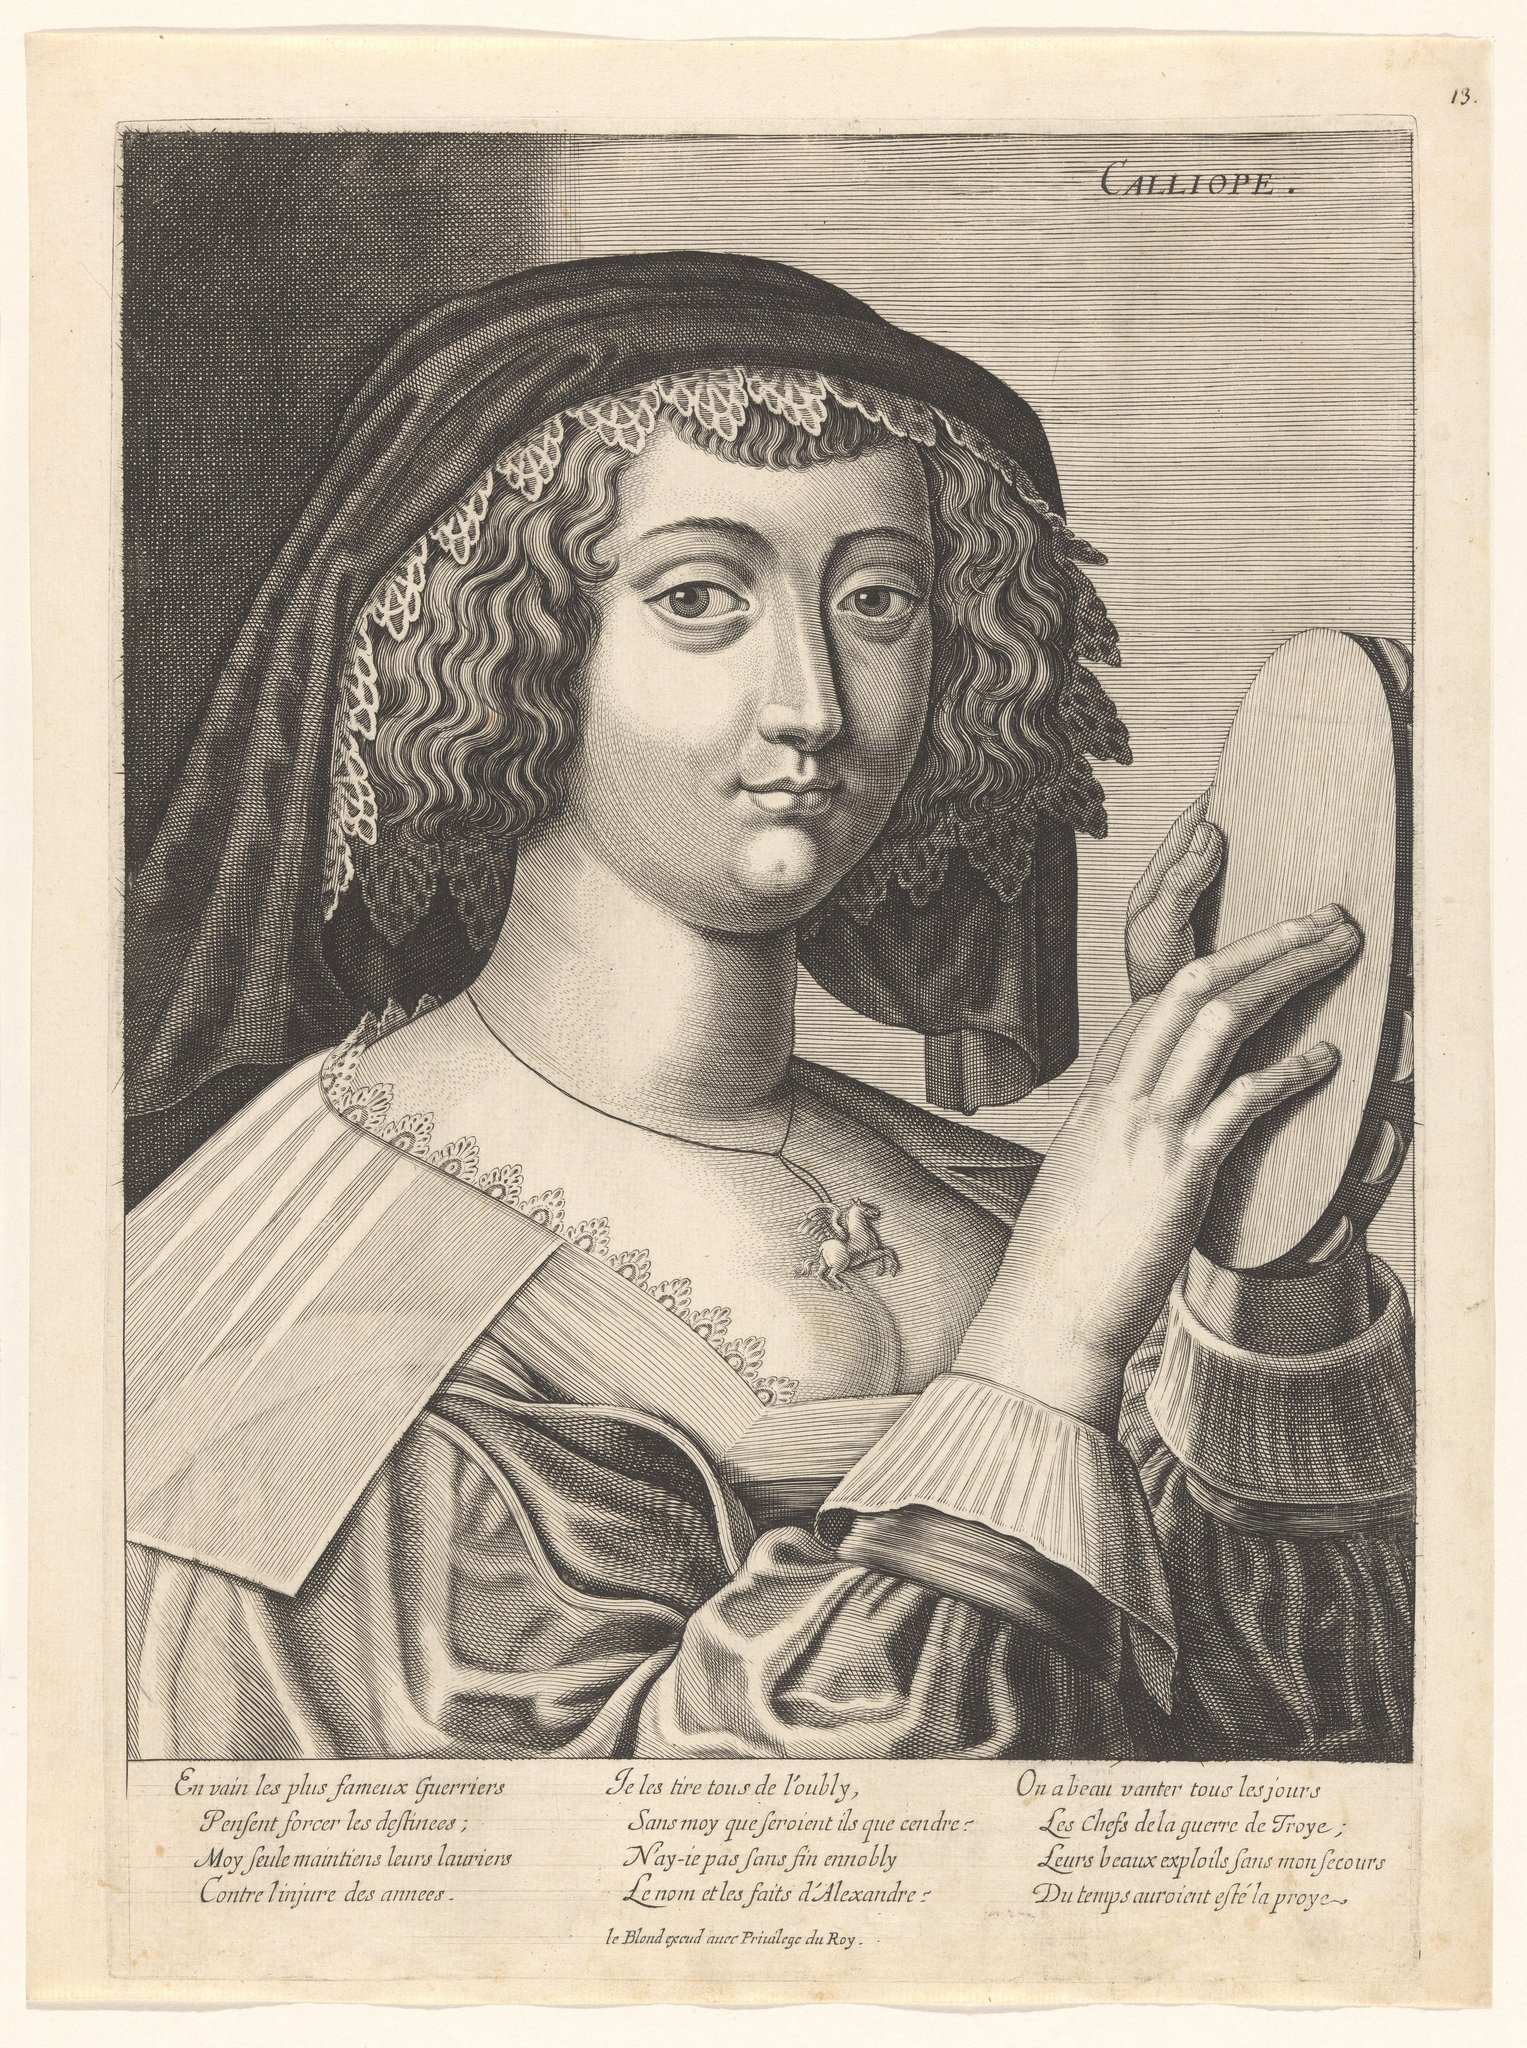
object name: print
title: Apollo and the Nine Muses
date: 1630-1635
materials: paper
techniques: engraving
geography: paris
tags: calliope (one of the muses); 'calliope' (ripa), tambourine, one person playing percussion instrument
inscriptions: collector's mark: Lugt 2760, collector's mark: Lugt 2228, number: ‘13’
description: While there are numerous depictions of Apollo and the nine muses, these ones are exceptional. In Greek mythology, Apollo is the god of music and harmony and his sisters, the muses, are the goddesses of art and science and symbols of inspiration. Le Blond portrayed each of them separately, making music. Dressed and coiffed according to the latest Parisian fashion around 1630, they have thus become contemporary.